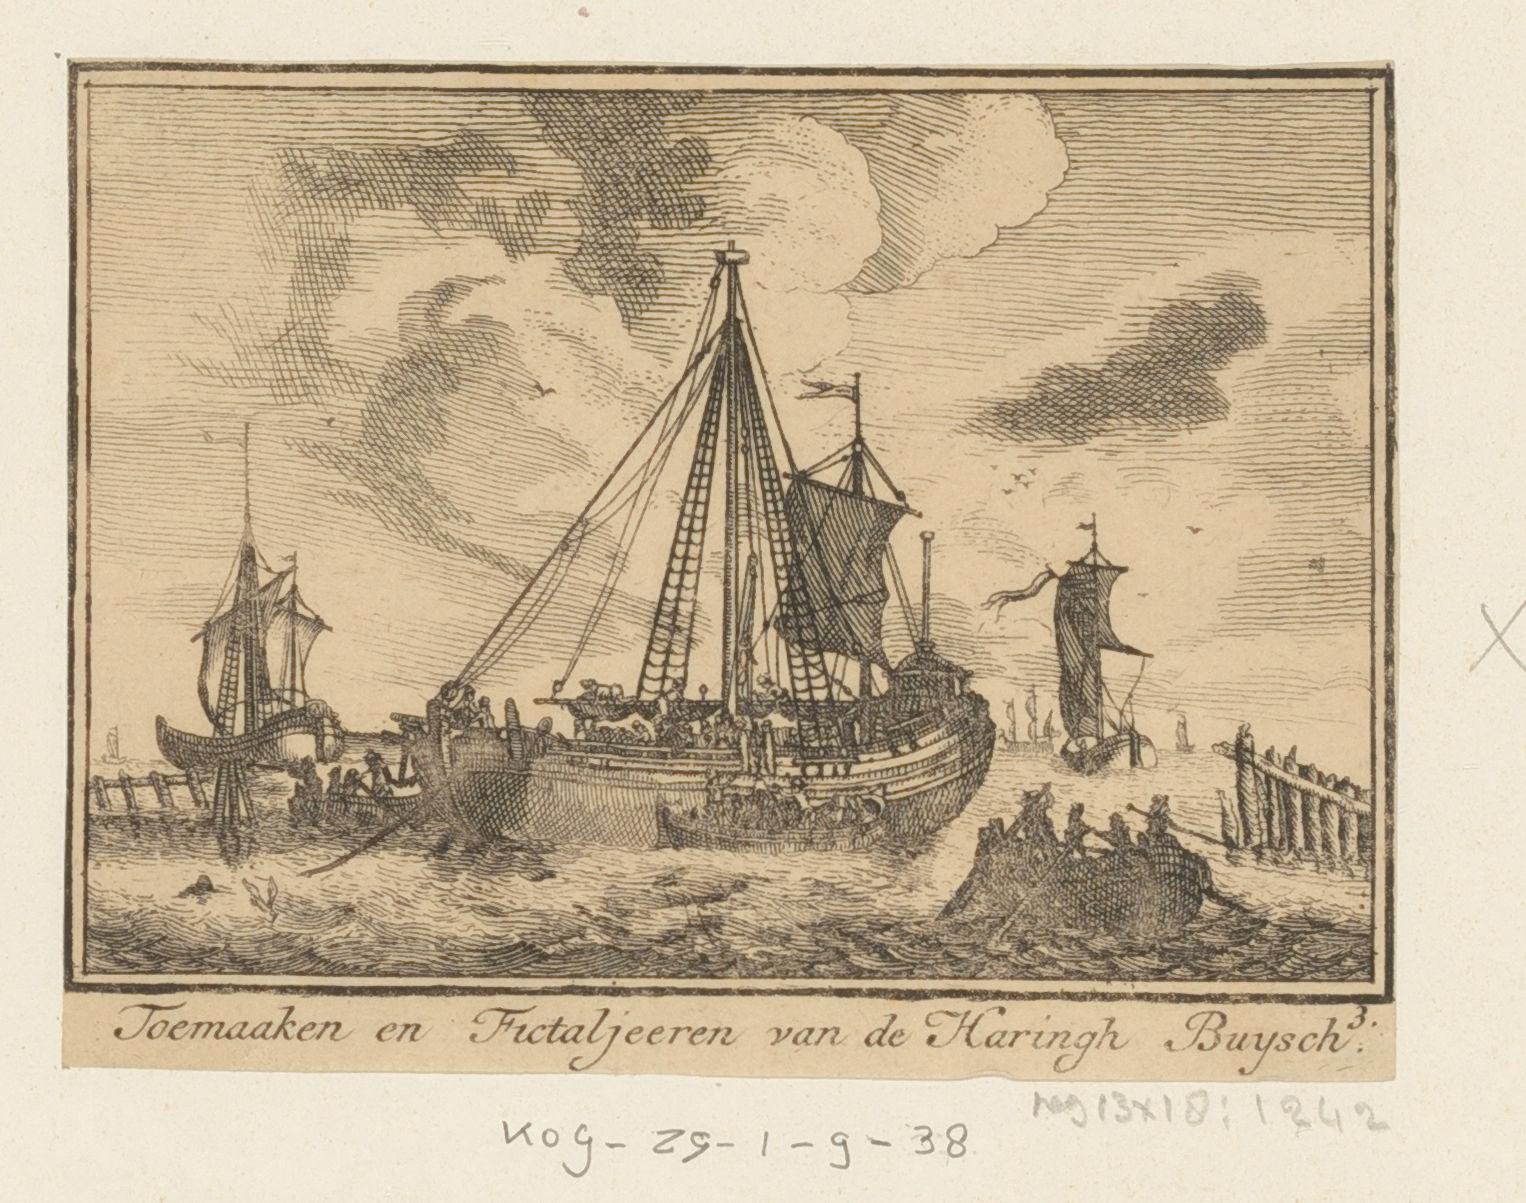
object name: print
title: Uitrusten en bevoorraden van de haringbuis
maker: Anonymous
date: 1728-1775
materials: paper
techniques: engraving, etching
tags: harbour, fishing net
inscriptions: stamp, collector's mark: Lugt 1641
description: Prenten zijn een verkleinde versie van de serie Groote Visserij, Visschers Atlas tot Amsterdam. Prenten door Adolf van der Laan, naar tekeningen van Sieuwert van der Meulen en uitgegeven door Pieter Schenk II. De serie bestaat uit zeventien platen over de haringvisserij en zestien platen over de walvisvangst. De serie is waarschijnlijk rond 1720 uitgegeven. De kleine prenten werden met vier voorstellingen op een plaat gedrukt. Elke afbeelding werd genummerd.